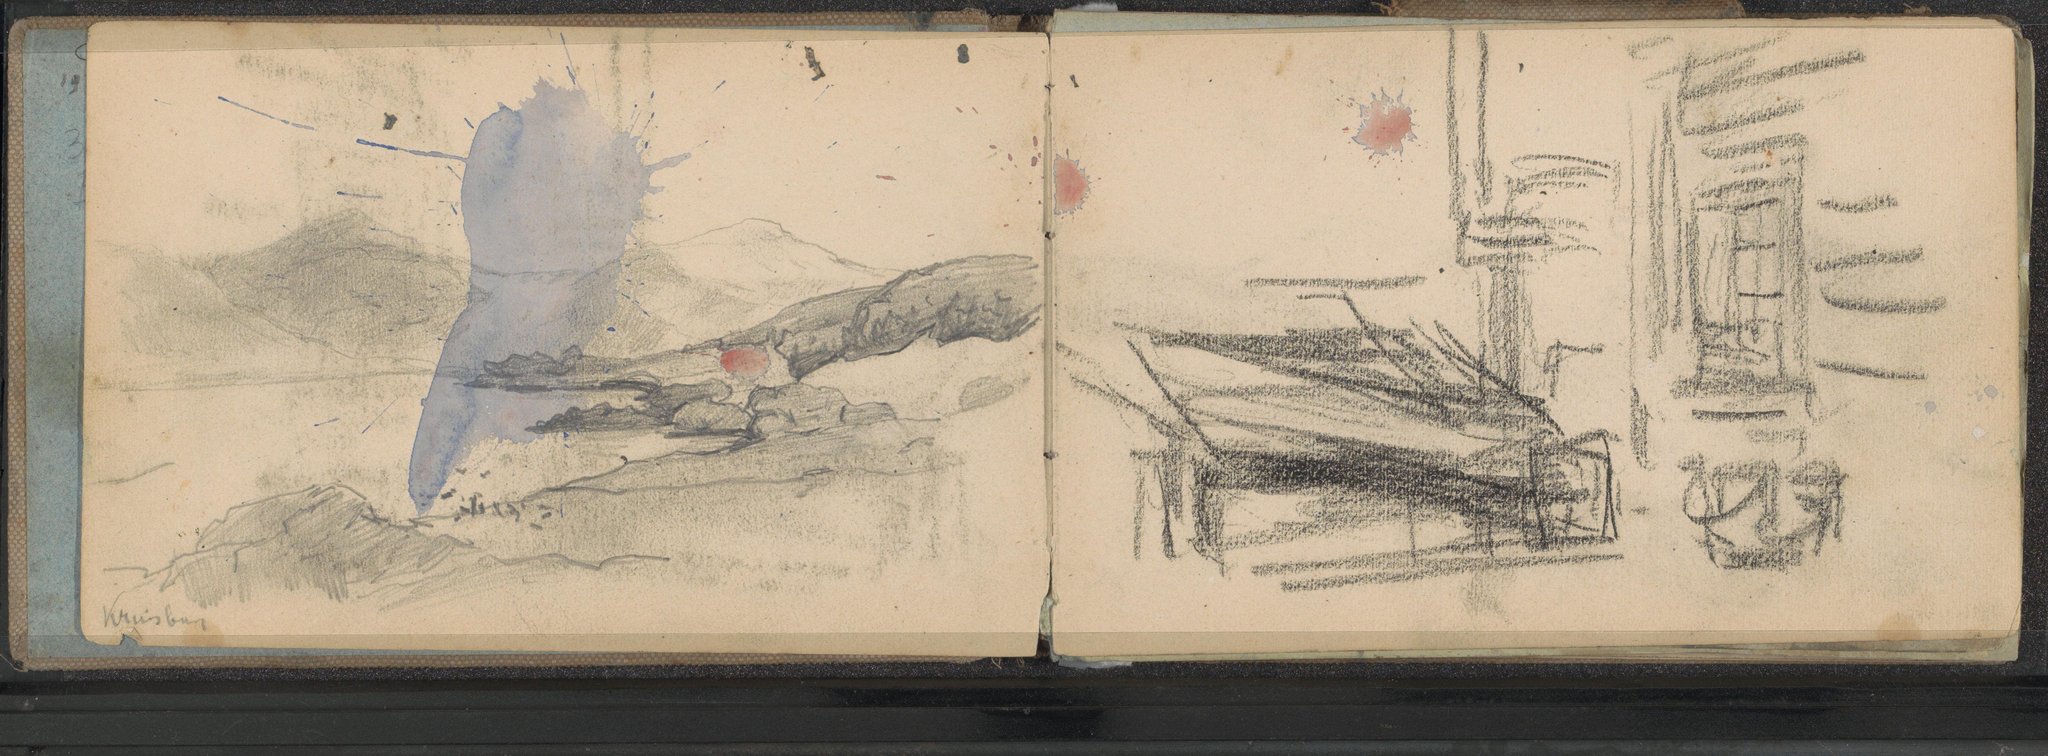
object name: sketchbook leaf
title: Huis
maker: louis apol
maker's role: draughtsman, painter, print maker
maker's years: 1850-1936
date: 1880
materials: chalk, paper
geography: novaya zemlya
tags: civic architecture; edifices; dwellings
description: Blad 2 recto uit een schetsboek met 35 bladen betekend tijdens de expeditie naar Nova Zembla in 1880.